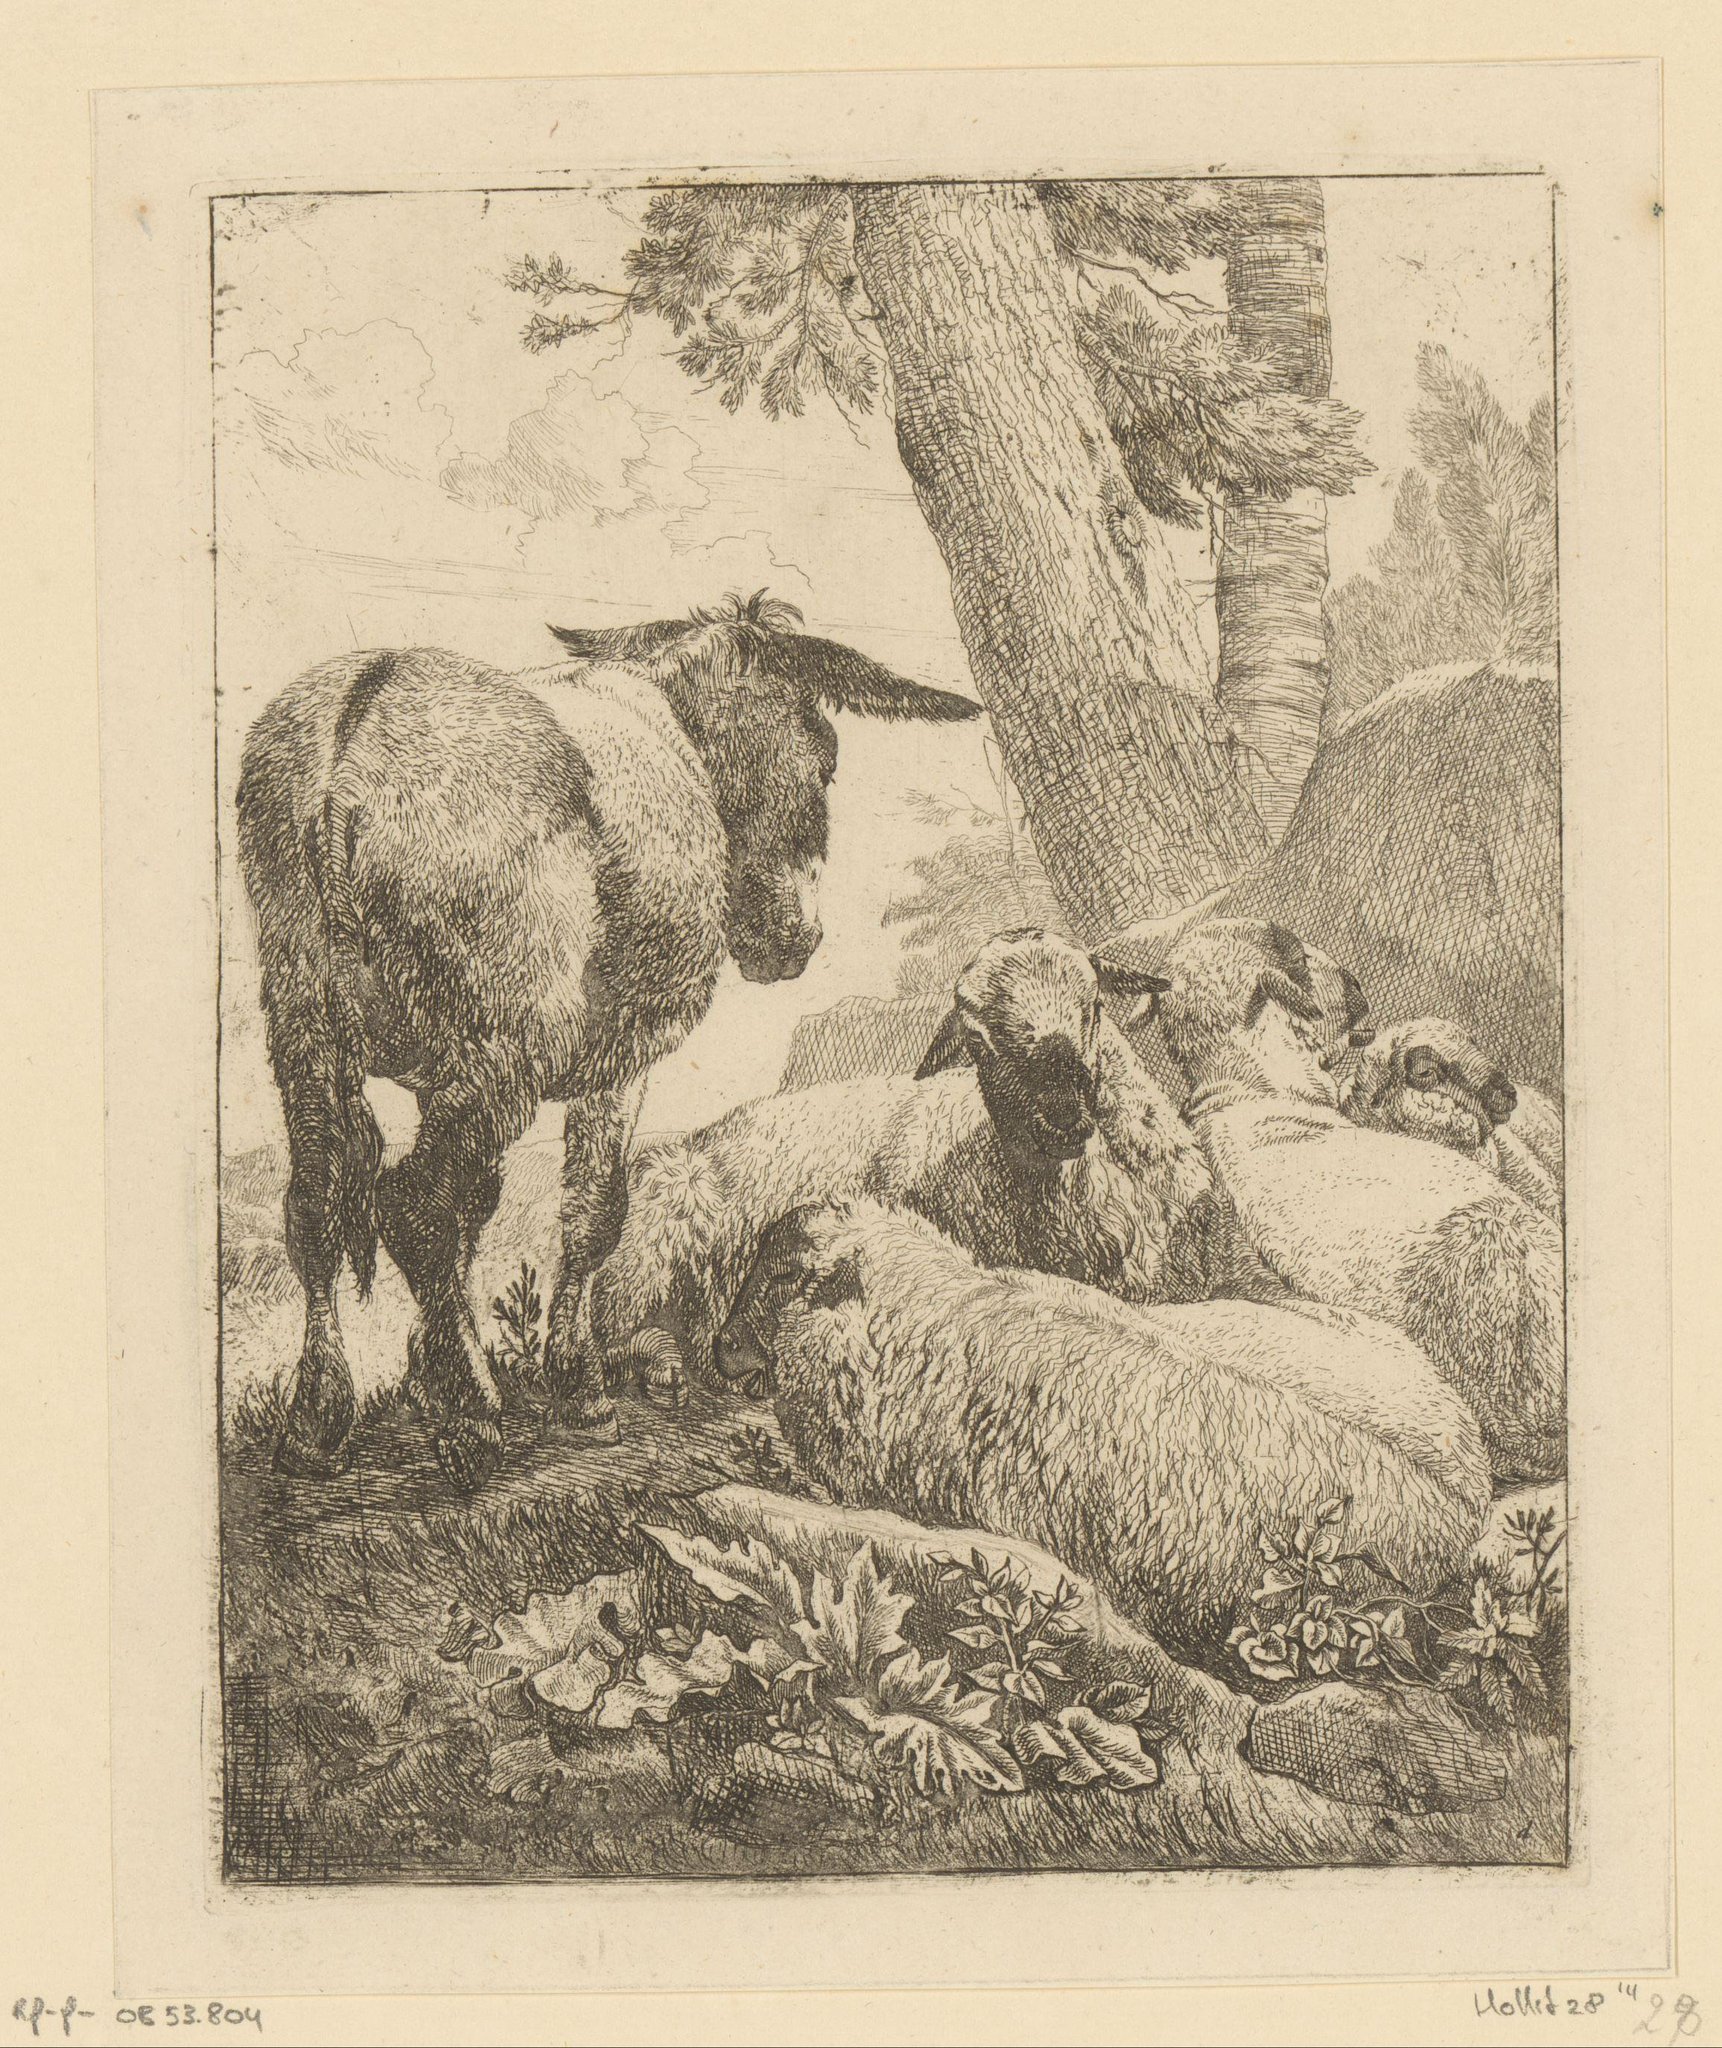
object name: print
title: Staande ezel en vier liggende schapen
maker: johann heinrich roos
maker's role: draughtsman, print maker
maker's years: 1631-1685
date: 1668-1670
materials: paper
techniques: engraving, etching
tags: landscapes, ass, donkey, sheep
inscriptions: collector's mark: Lugt 240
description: Serie van twaalf prenten, waarvan één titelprent. Deze staat rechtsonder genummerd met een d.